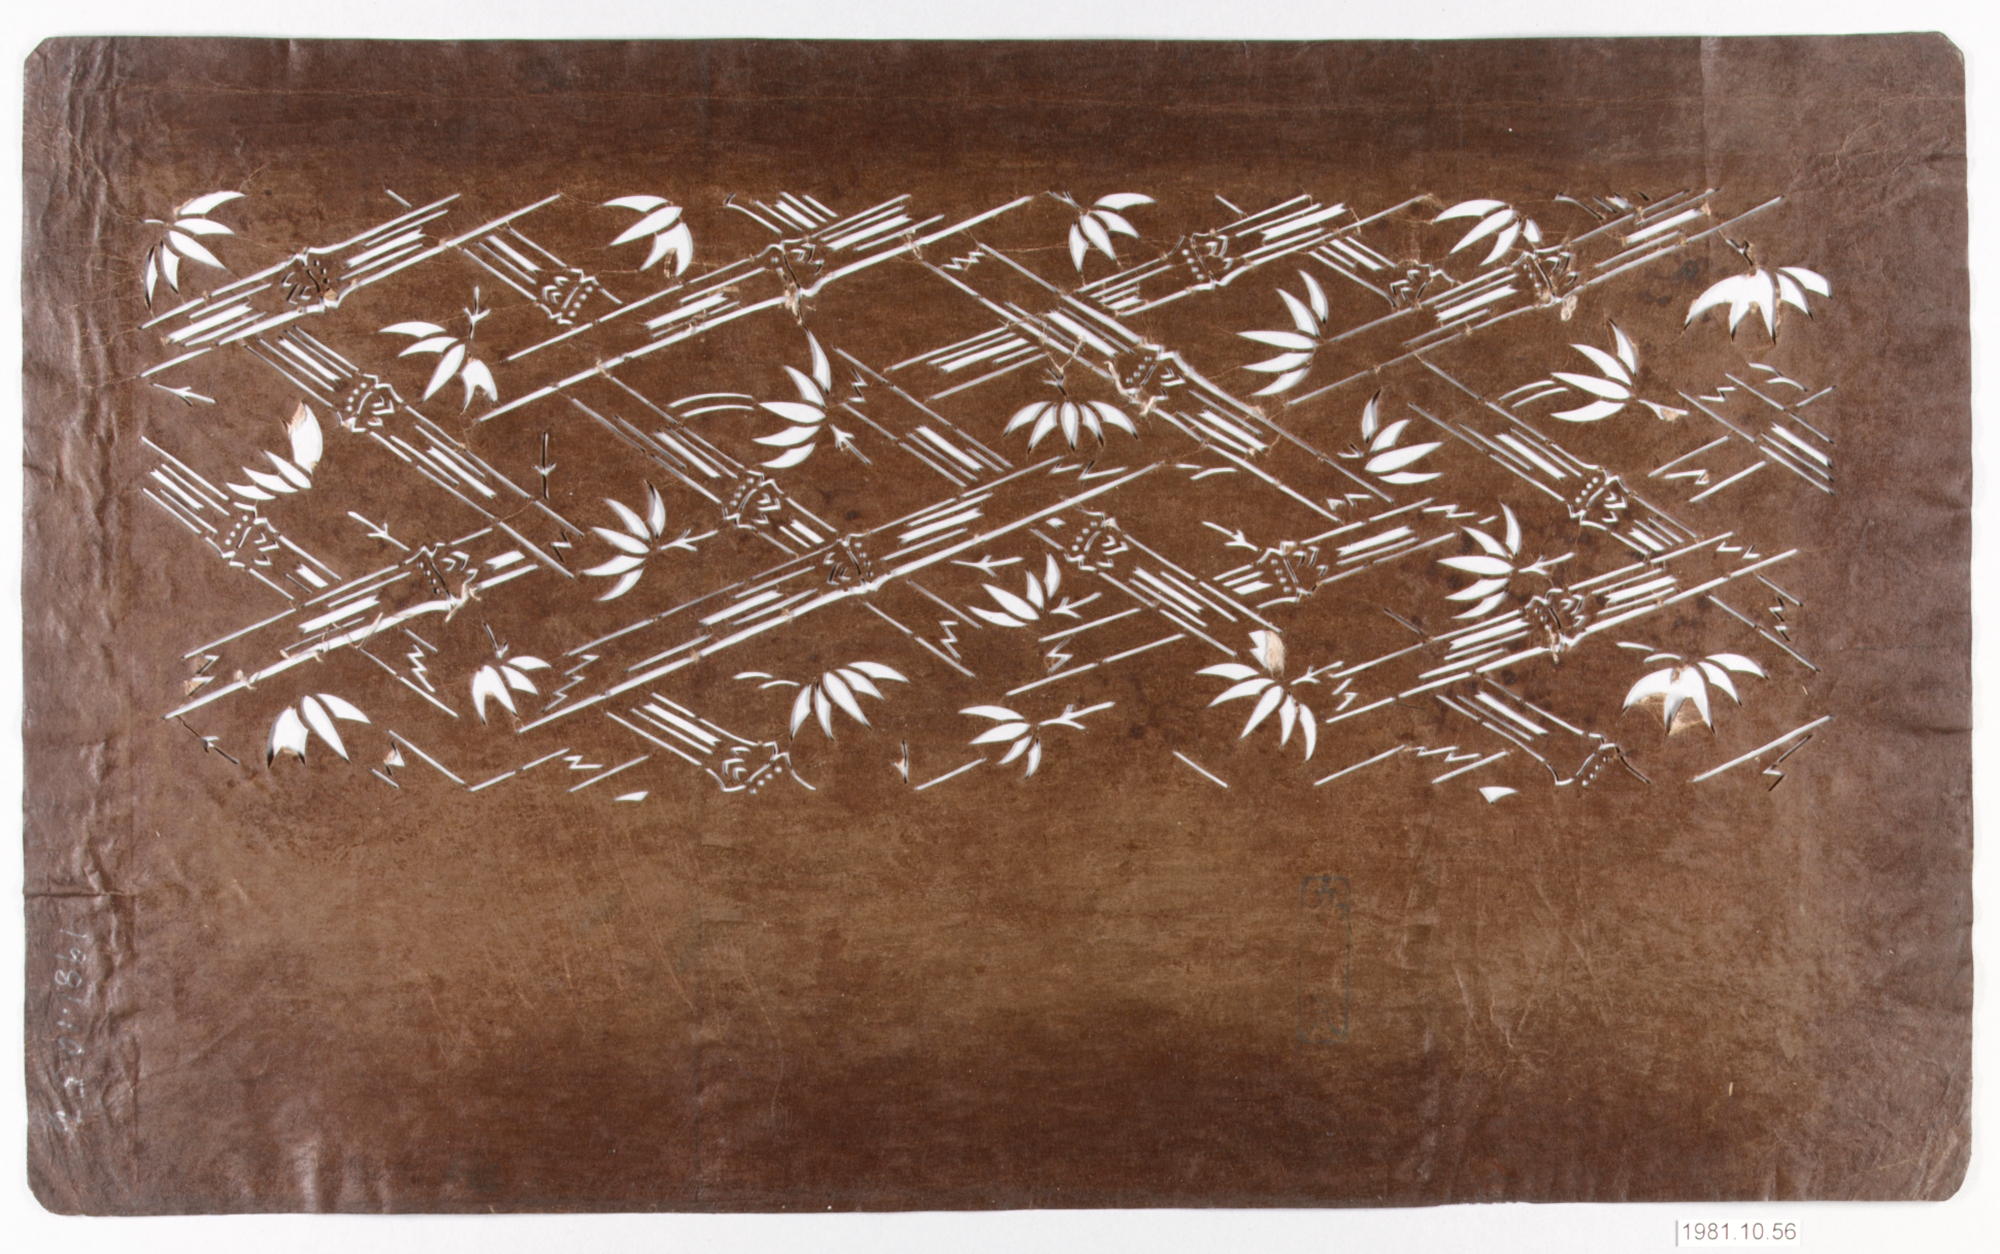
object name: stencil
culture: japanese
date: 1801-1900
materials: paper